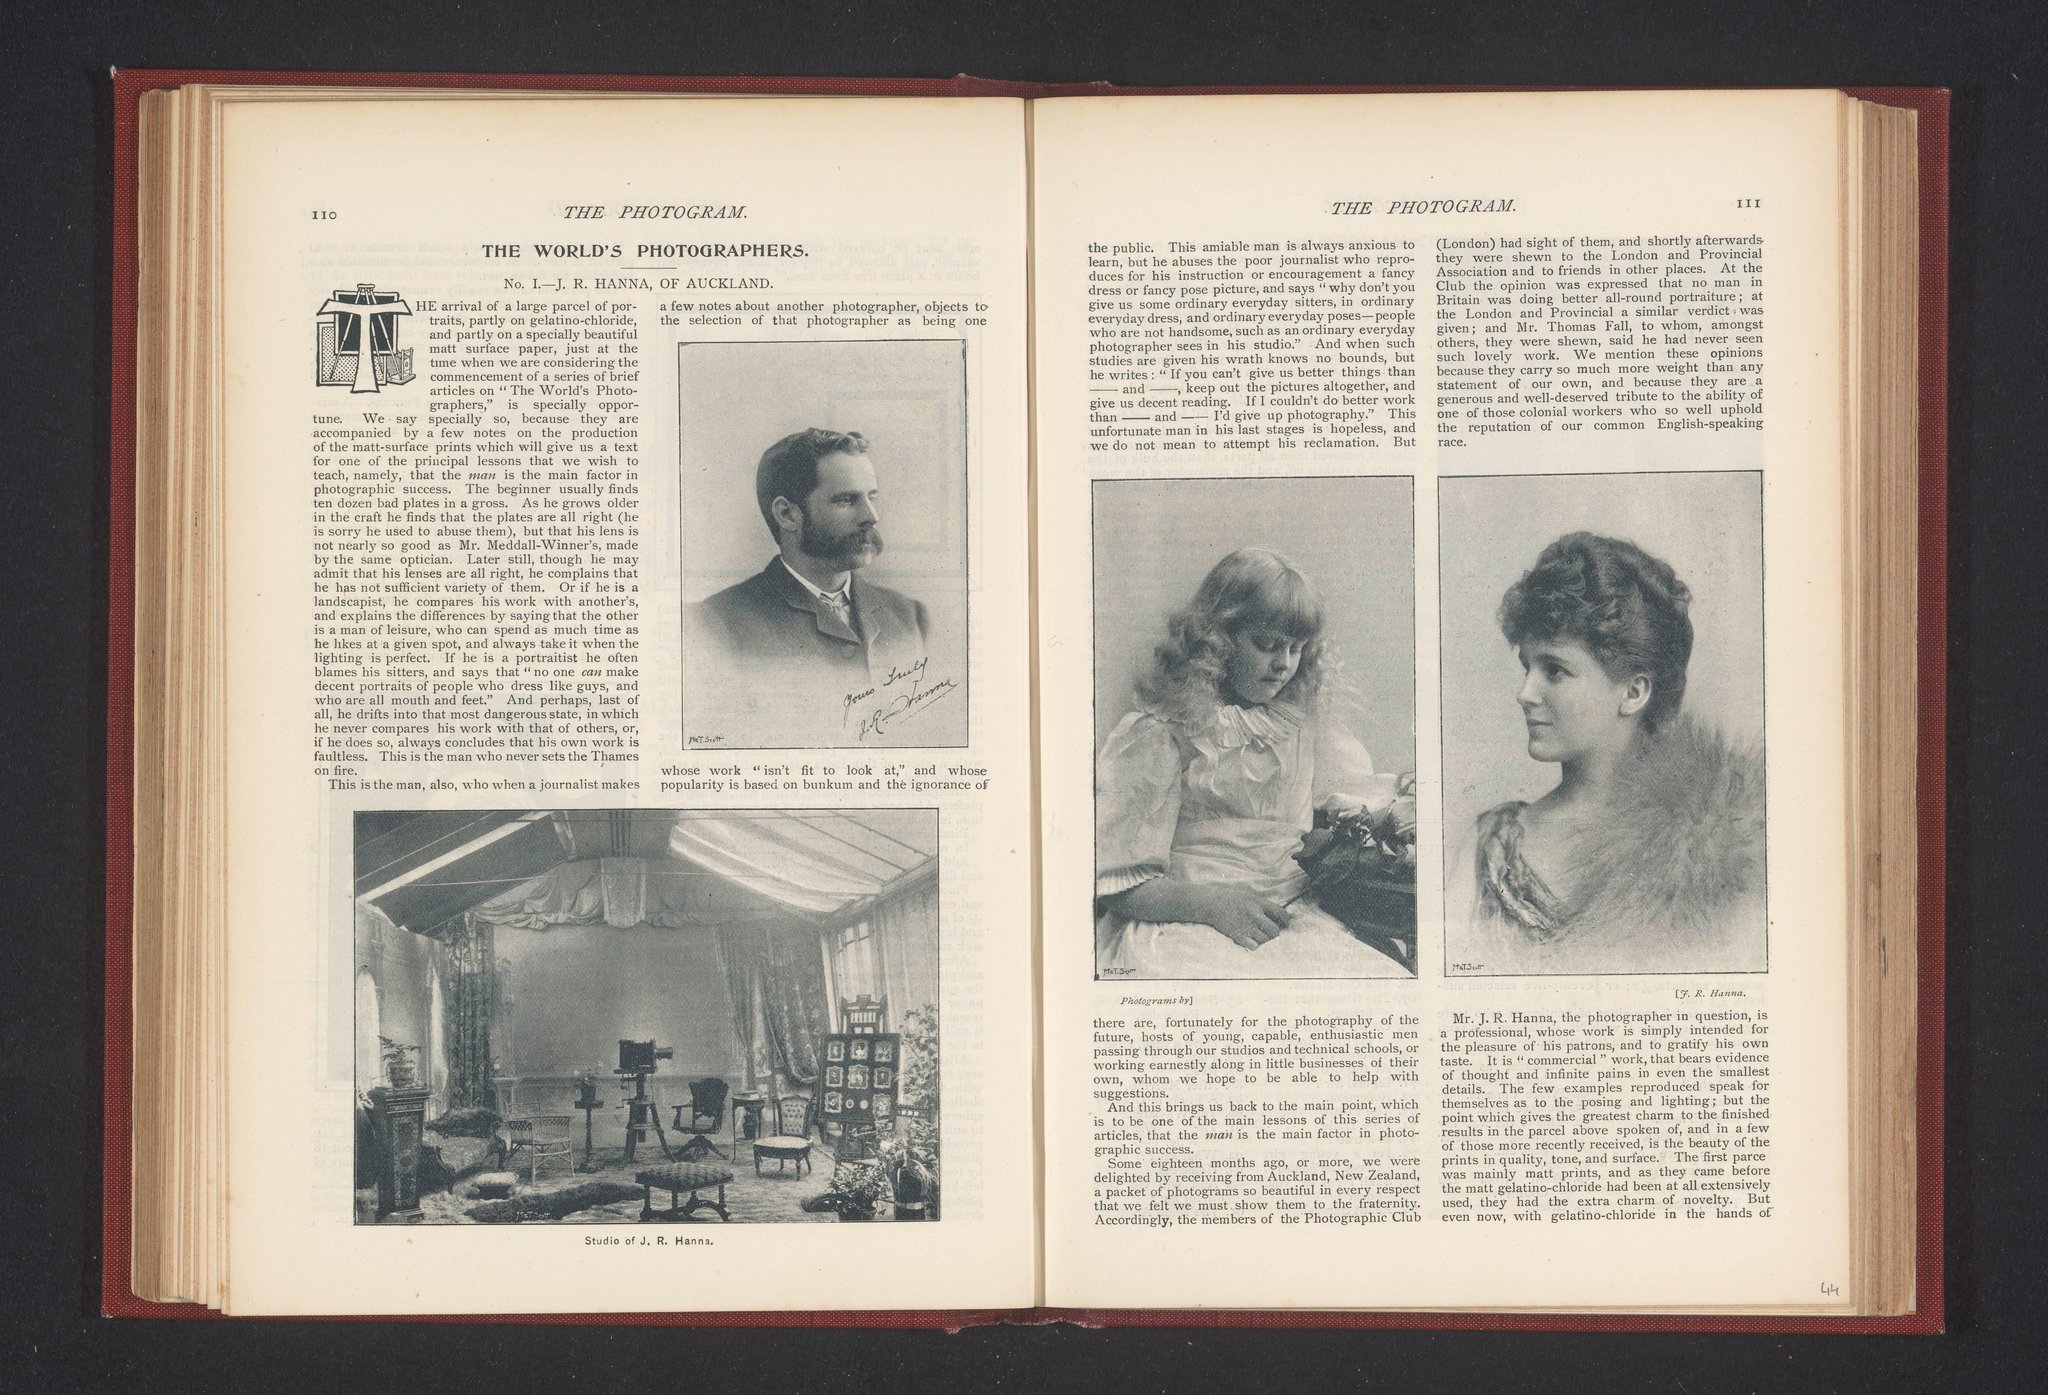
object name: photomechanical print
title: Twee portretten van onbekende jonge vrouwen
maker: j.r. hanna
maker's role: fotograaf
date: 1889-1894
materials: paper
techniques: autotype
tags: historical persons - bb - woman